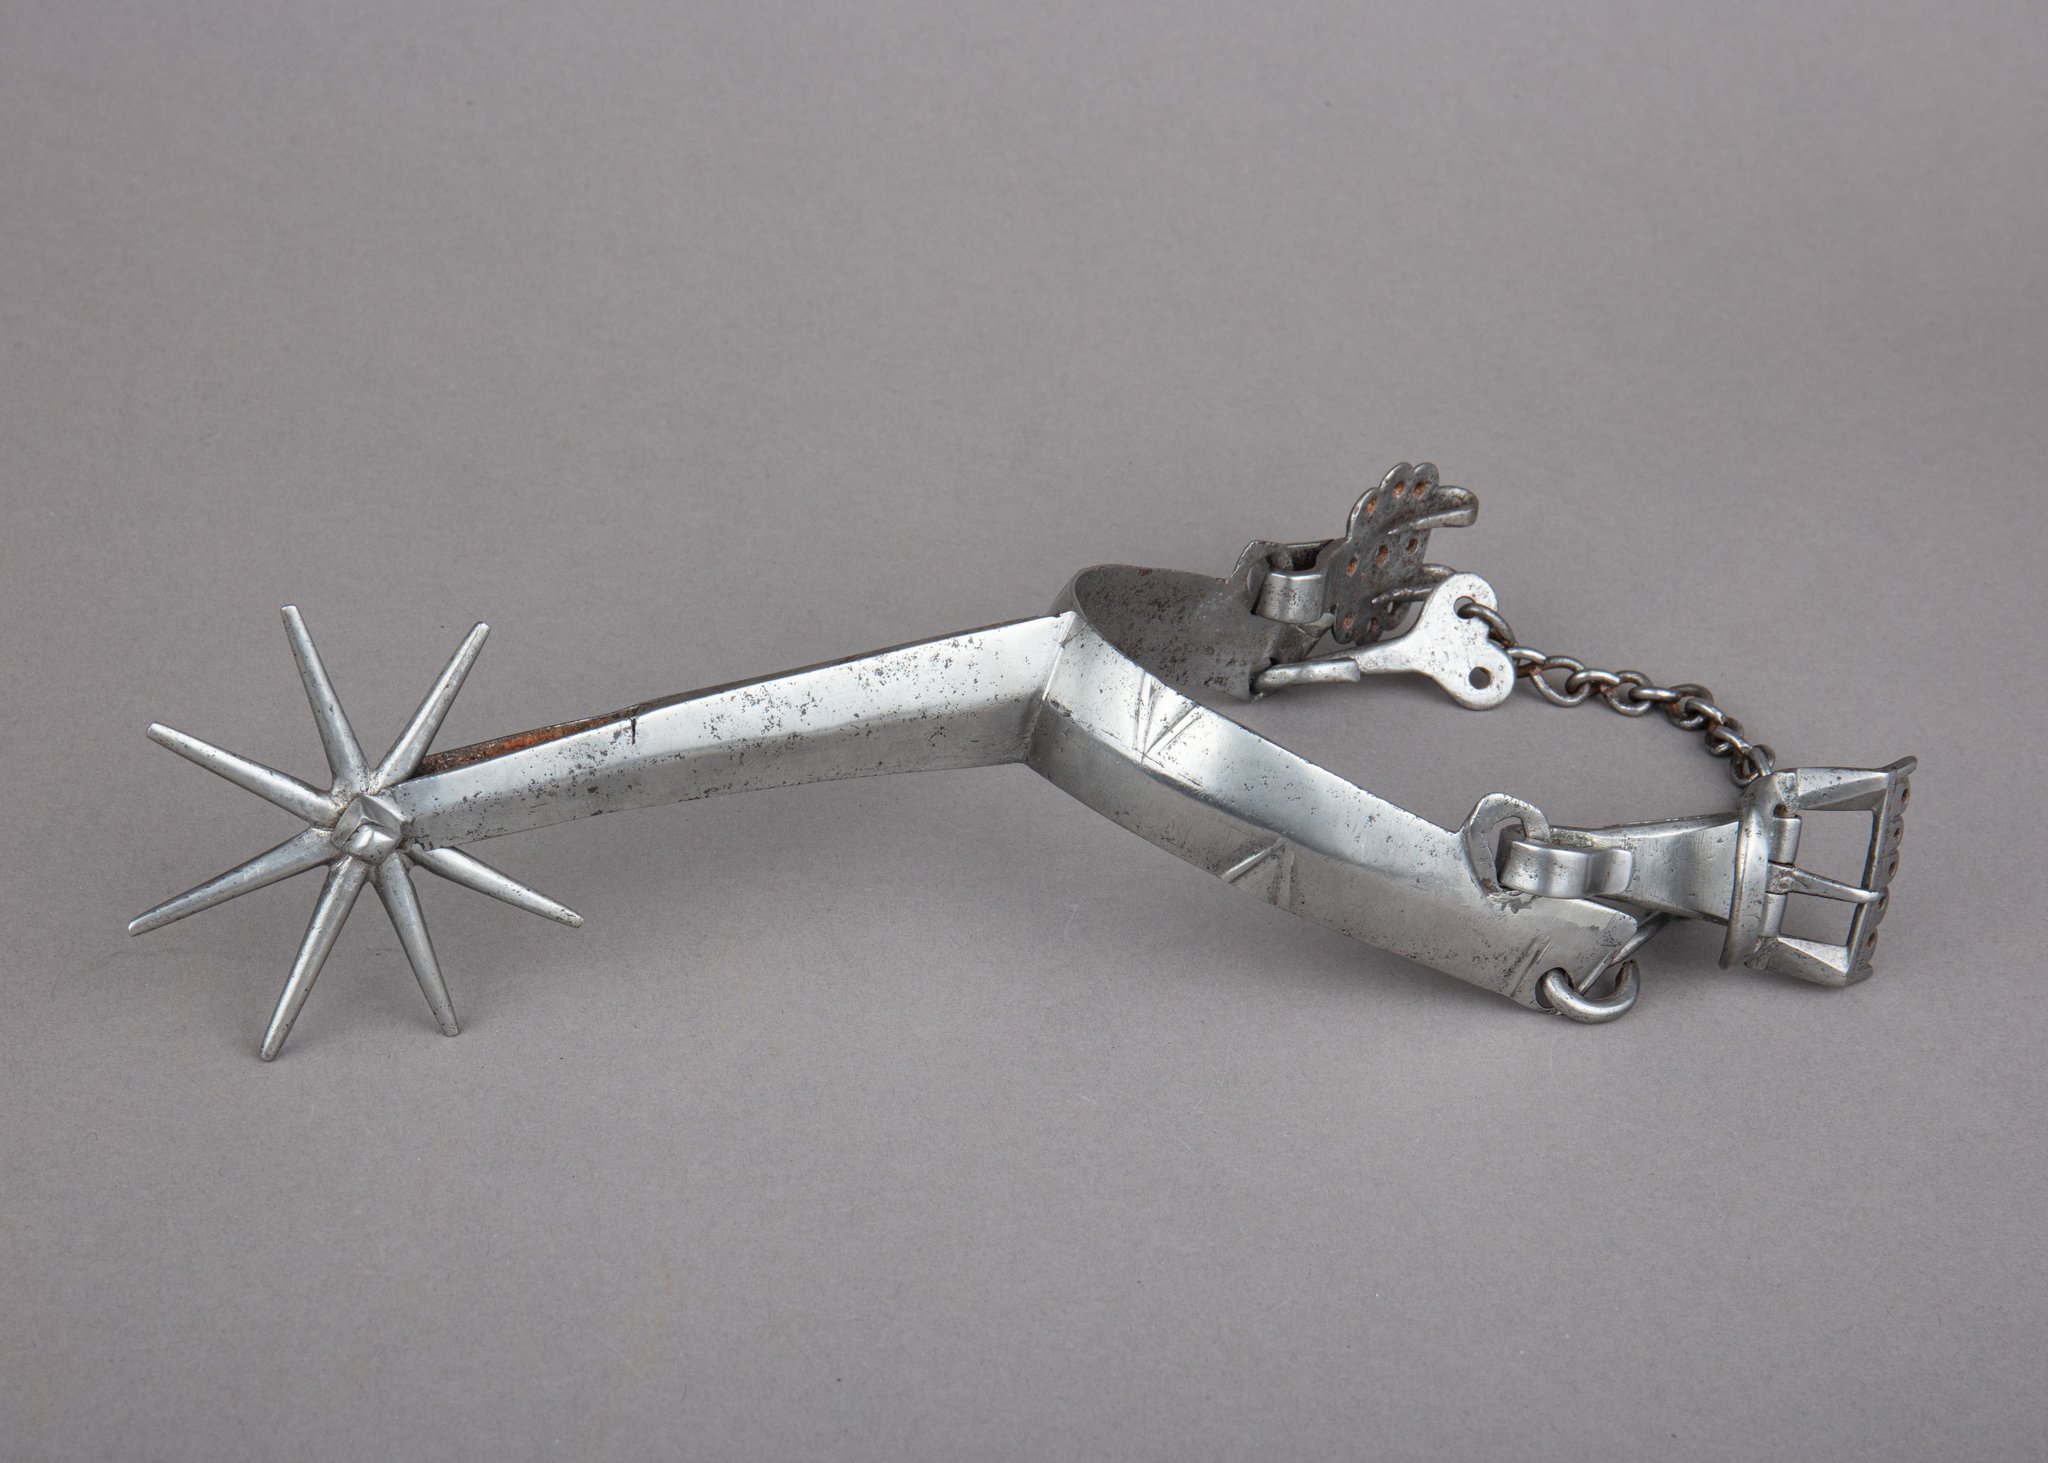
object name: spur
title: Rowel Spur (Right)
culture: german or hungarian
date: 1500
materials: metal alloy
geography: hungary